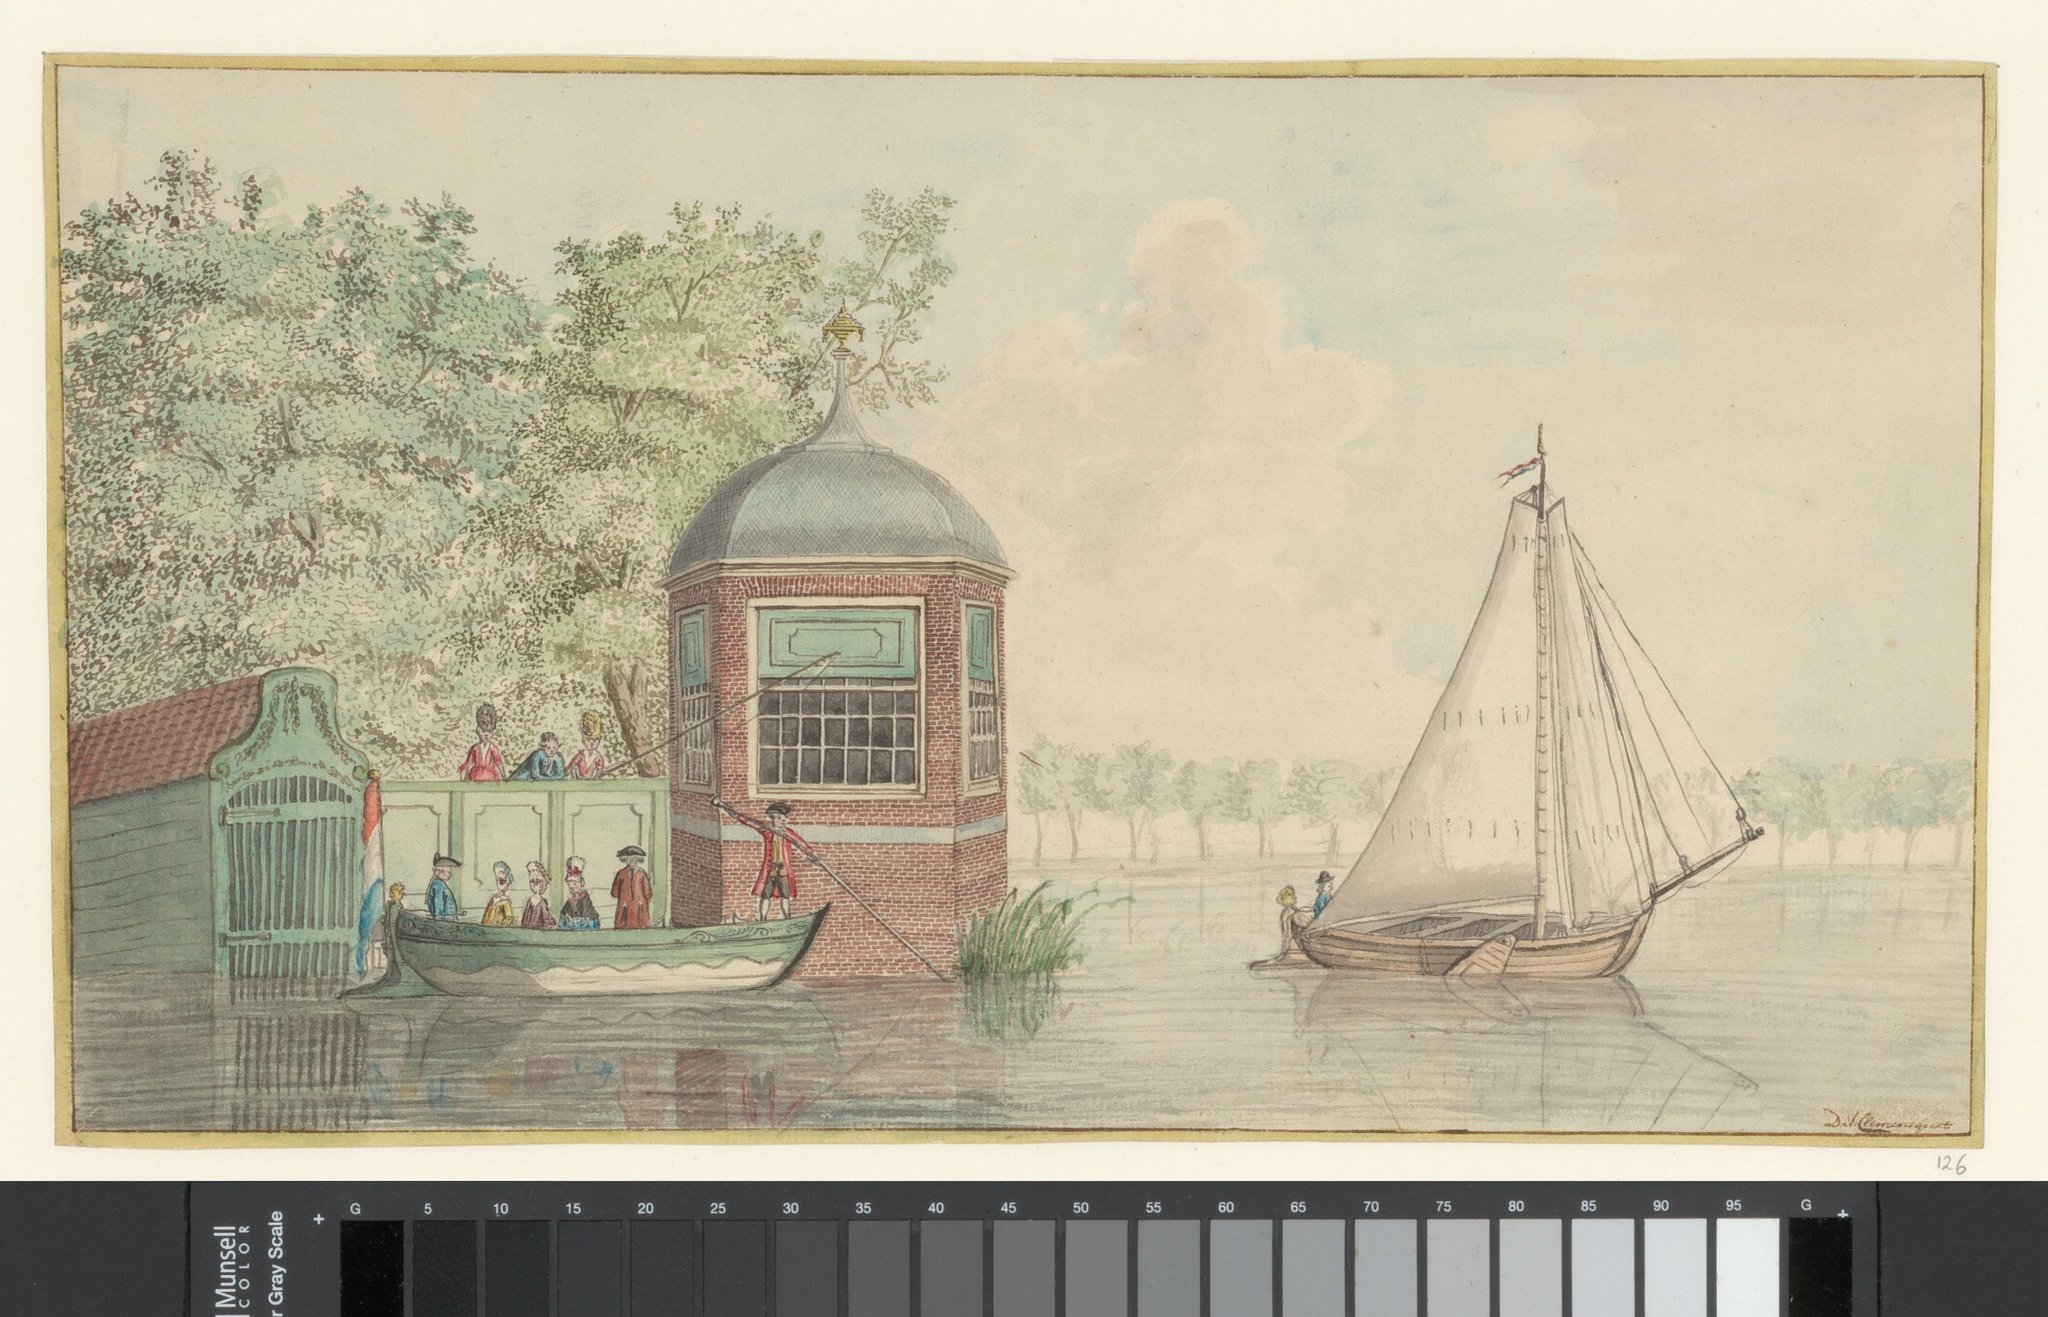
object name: drawing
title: Gezicht op Ambachtsheerlijkheid Nieuwer-Amstel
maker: dirk abraham clemens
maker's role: draughtsman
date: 1775-1825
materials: paper, pencil, watercolor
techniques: brush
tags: sailing-ship, sailing-boat, rowing-boat, canoe, etc., country-house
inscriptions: stamp, collector's mark: Lugt 1641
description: Onderwerpsrubrieken binnen de Atlas Zeden en Gewoonten: Zeden en Gewoonten in Engeren Zin, De Woning. Kastelen en buitenplaatsen. Holland (vervolg.)